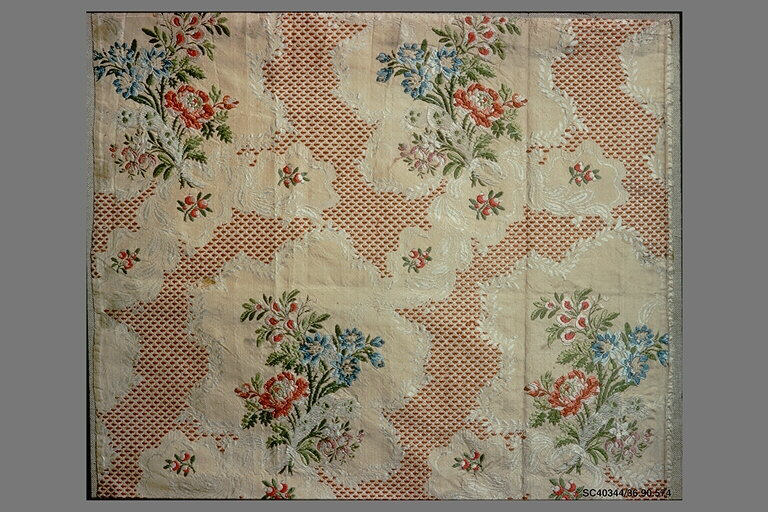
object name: piece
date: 1760-1770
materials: silk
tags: flowers,leaves